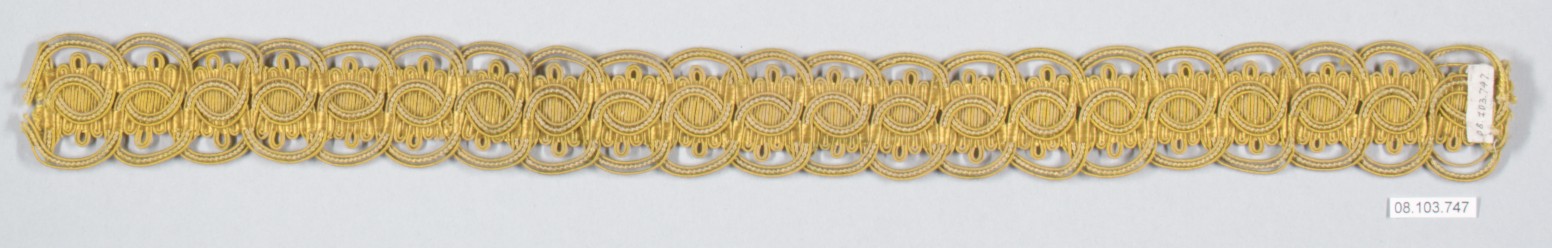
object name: gimp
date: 1701-1900